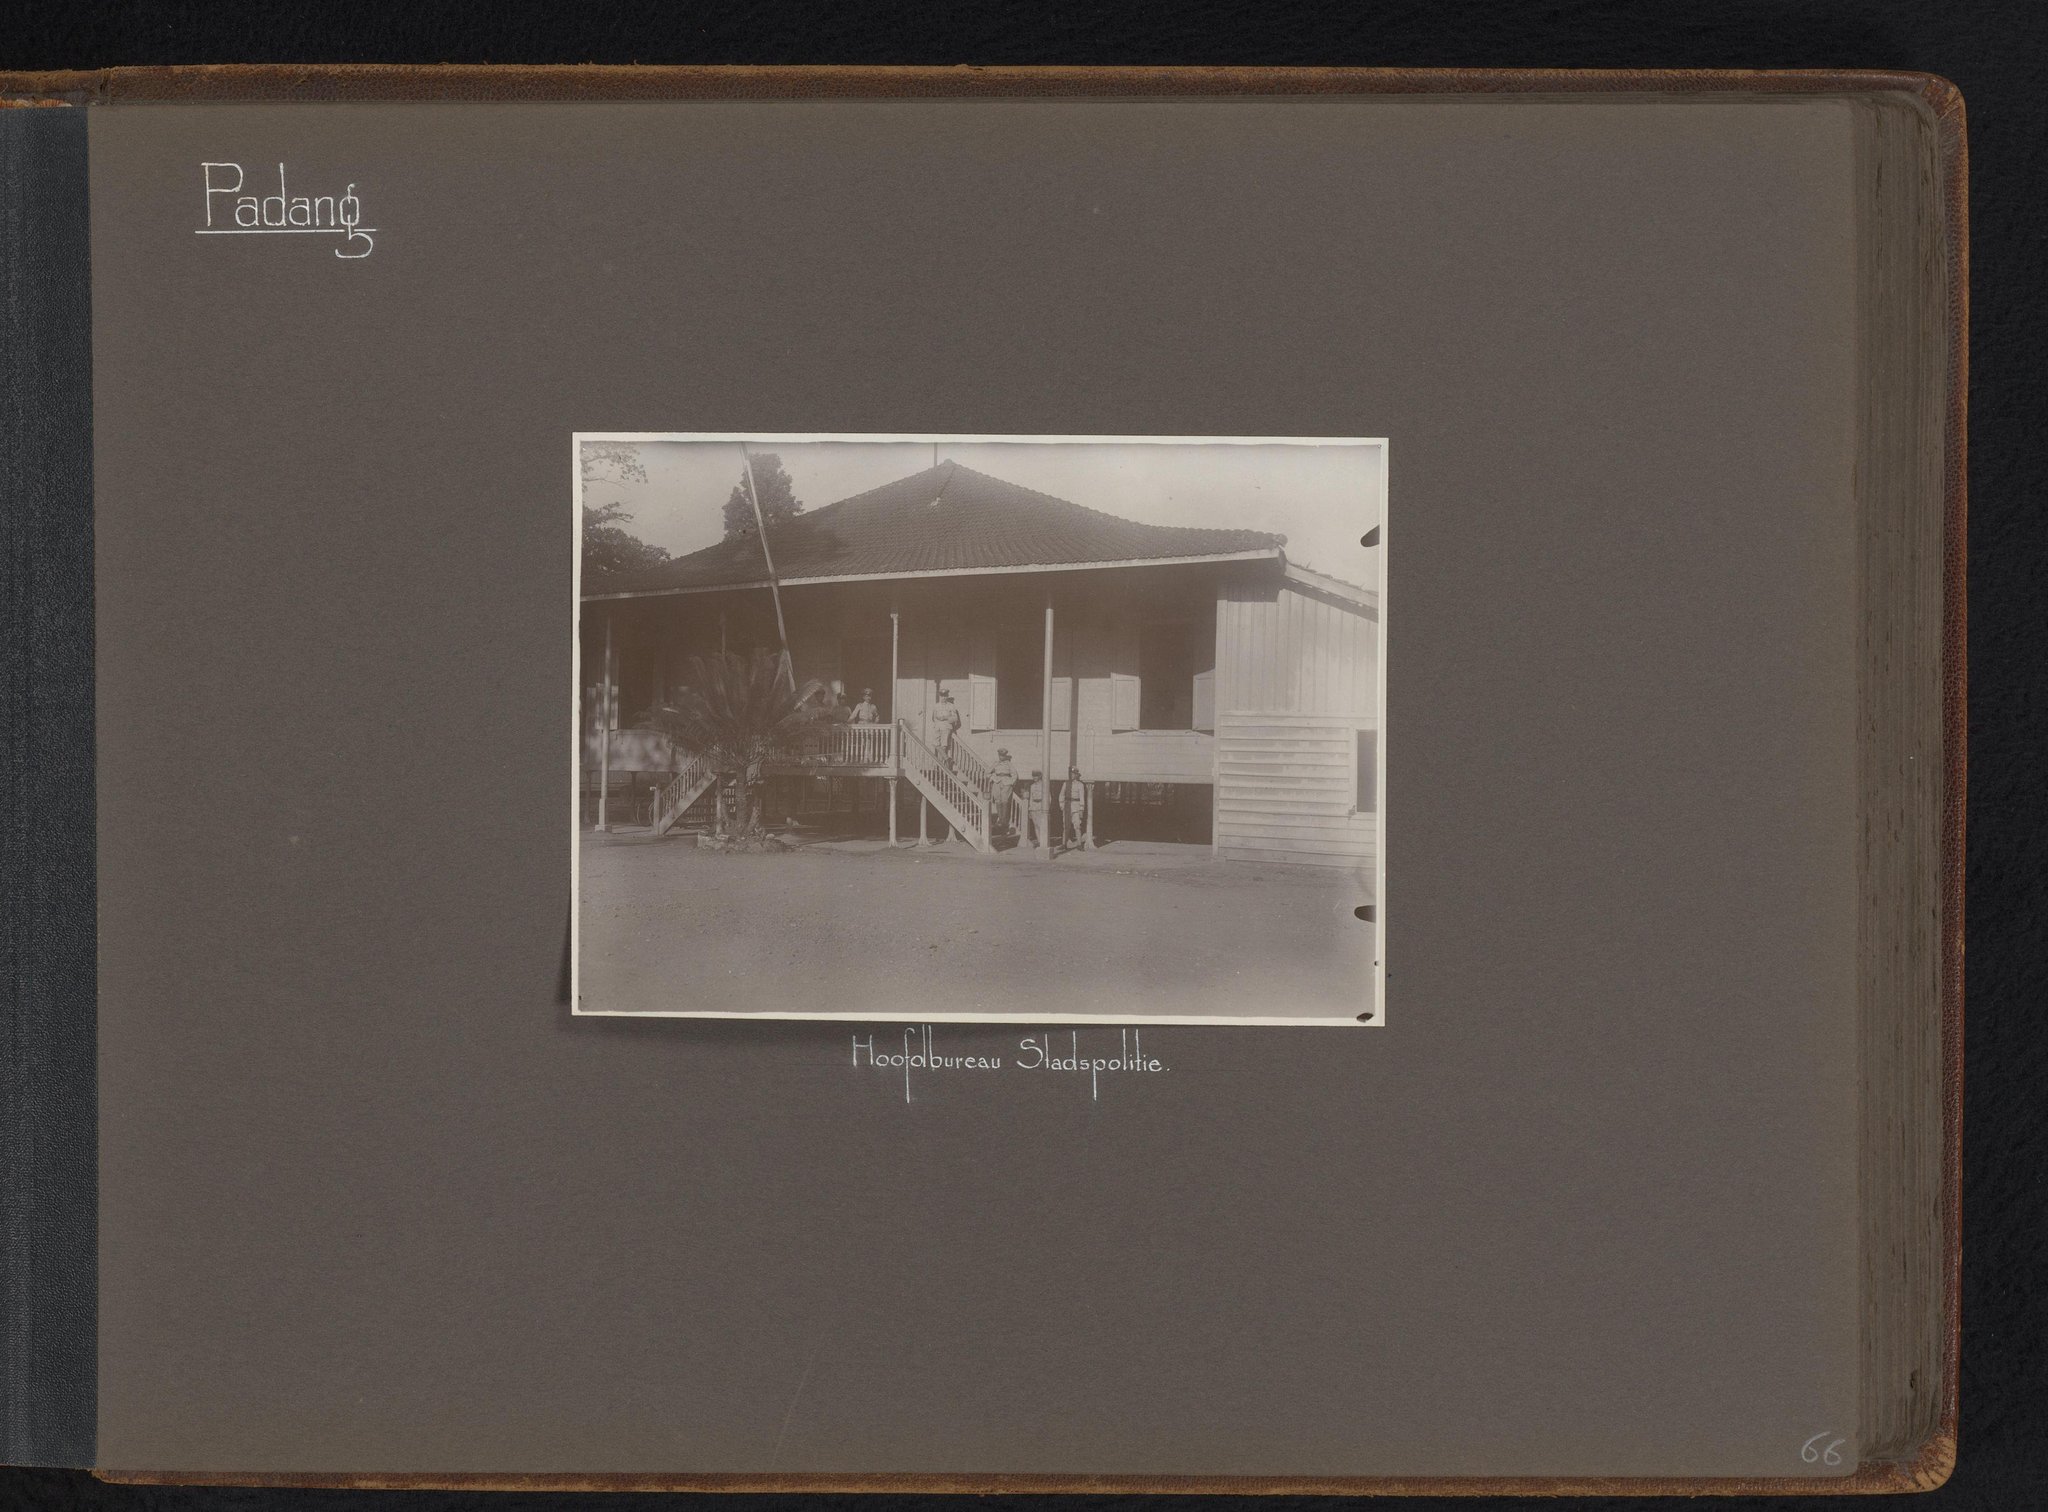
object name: album leaf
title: Padang / Hoofdbureau Stadspolitie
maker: Anonymous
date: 1925-1931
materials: cardboard, photographic support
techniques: gelatin silver print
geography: padang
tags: sumatra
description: Albumblad met één foto: het hoofdbureau van de stadspolitie te Padang op West-Sumatra. Onderdeel van het fotoalbum aangeboden aan S. Koster door de Vereeniging van Hoogere Politie Ambtenaren in Nederlandsch-Indië in 1931.